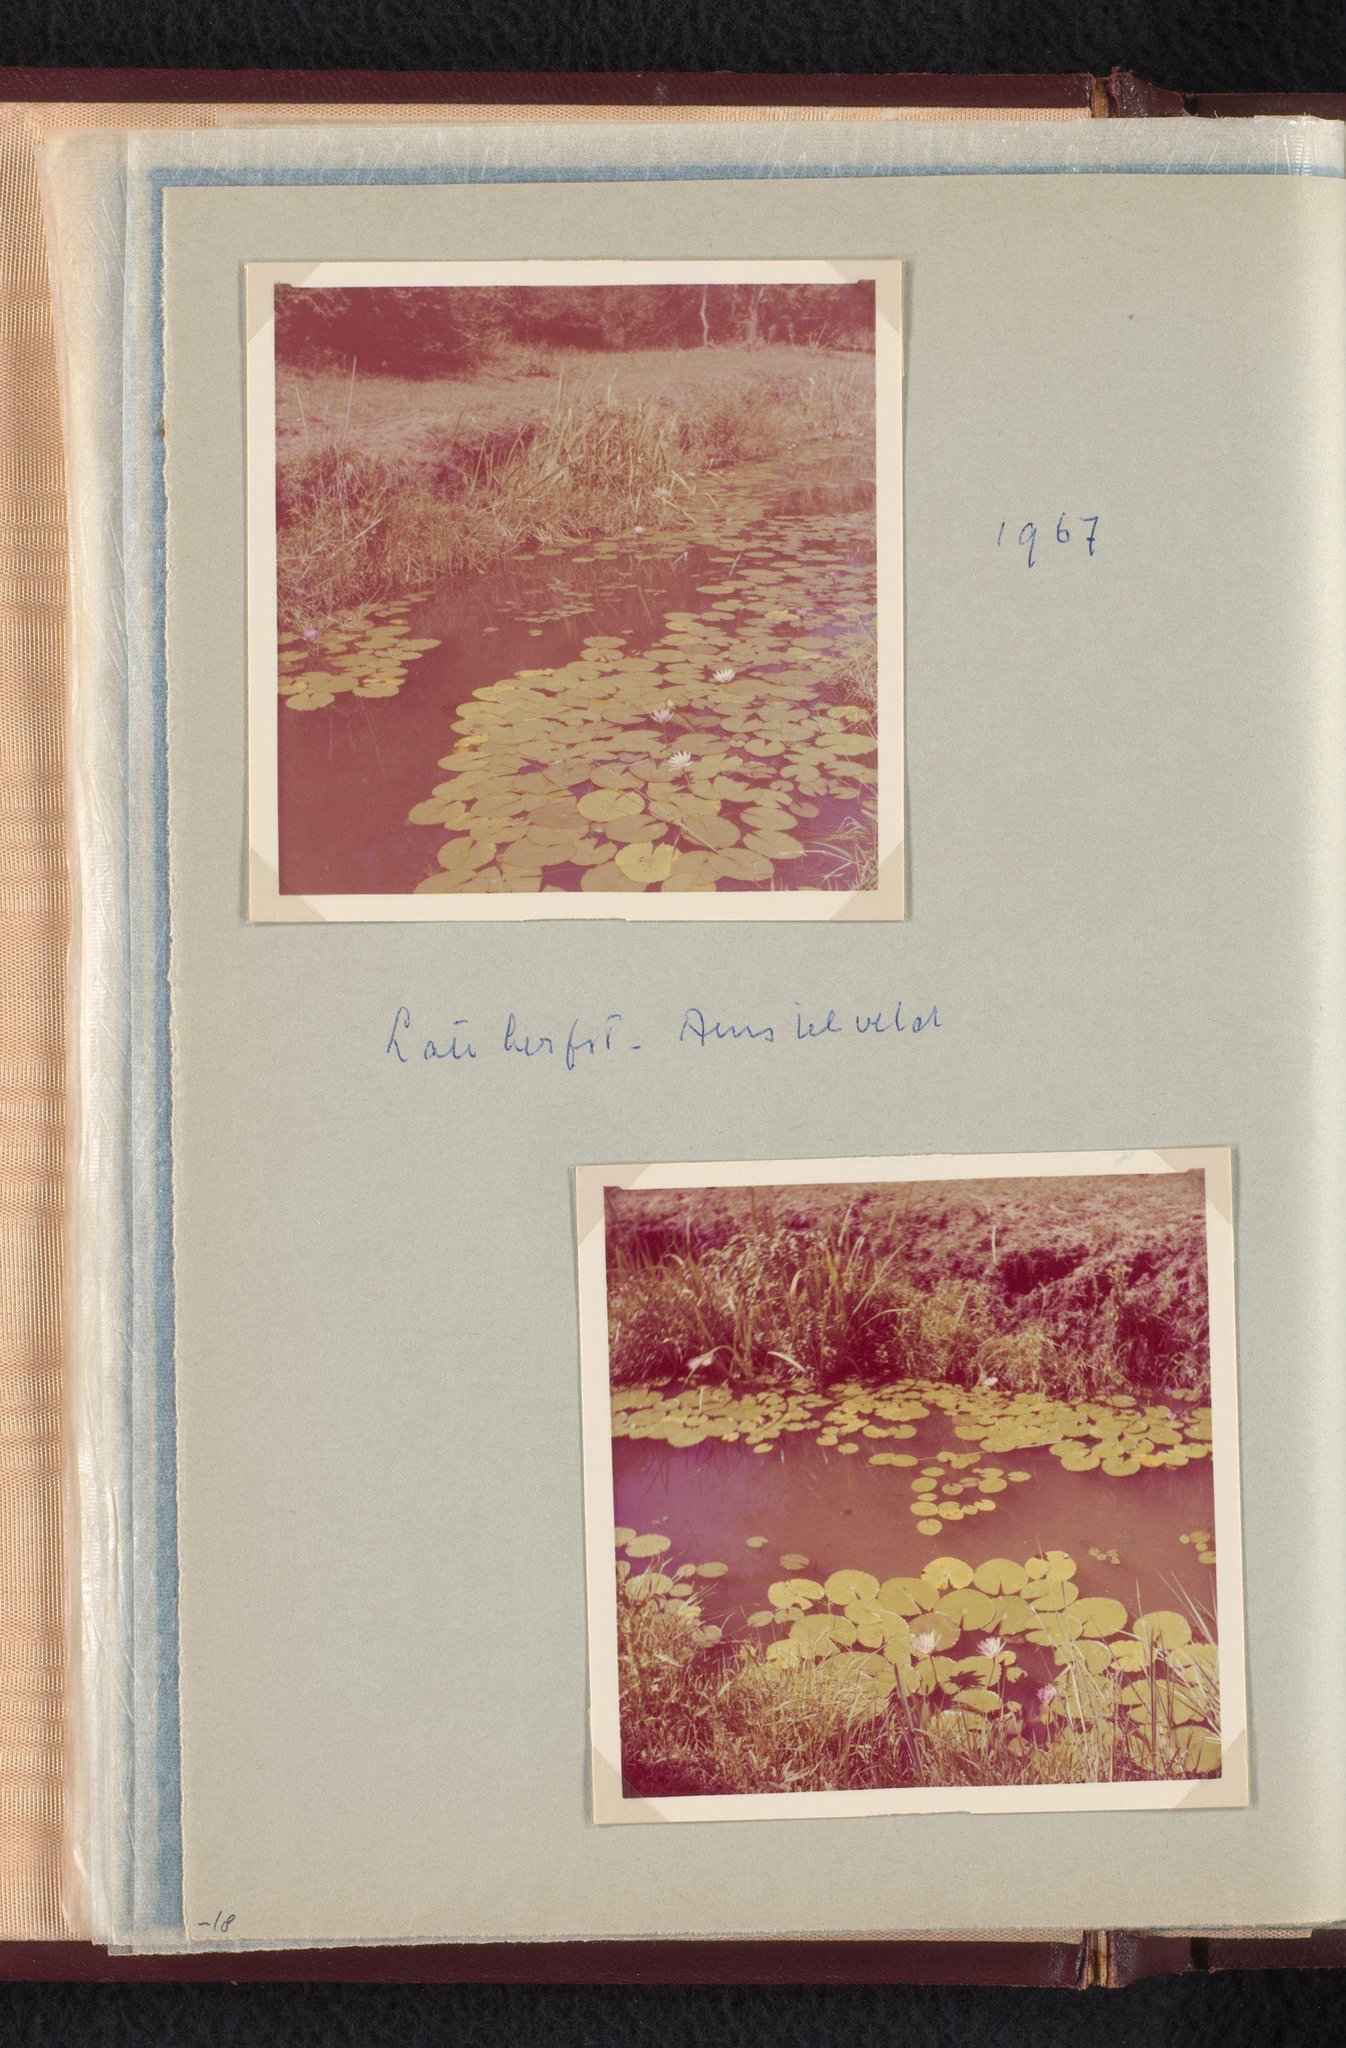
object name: album leaf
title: Waterlelies in Zuid-Afrika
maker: willem jacob van den berg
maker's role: boer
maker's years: 1902-1983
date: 1967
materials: paper, cardboard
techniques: chromogenic print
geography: south africa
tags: flowers: water-lily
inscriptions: inscription: ‘[...] - Amstelveld’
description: Deze foto's zijn onderdeel van een album.